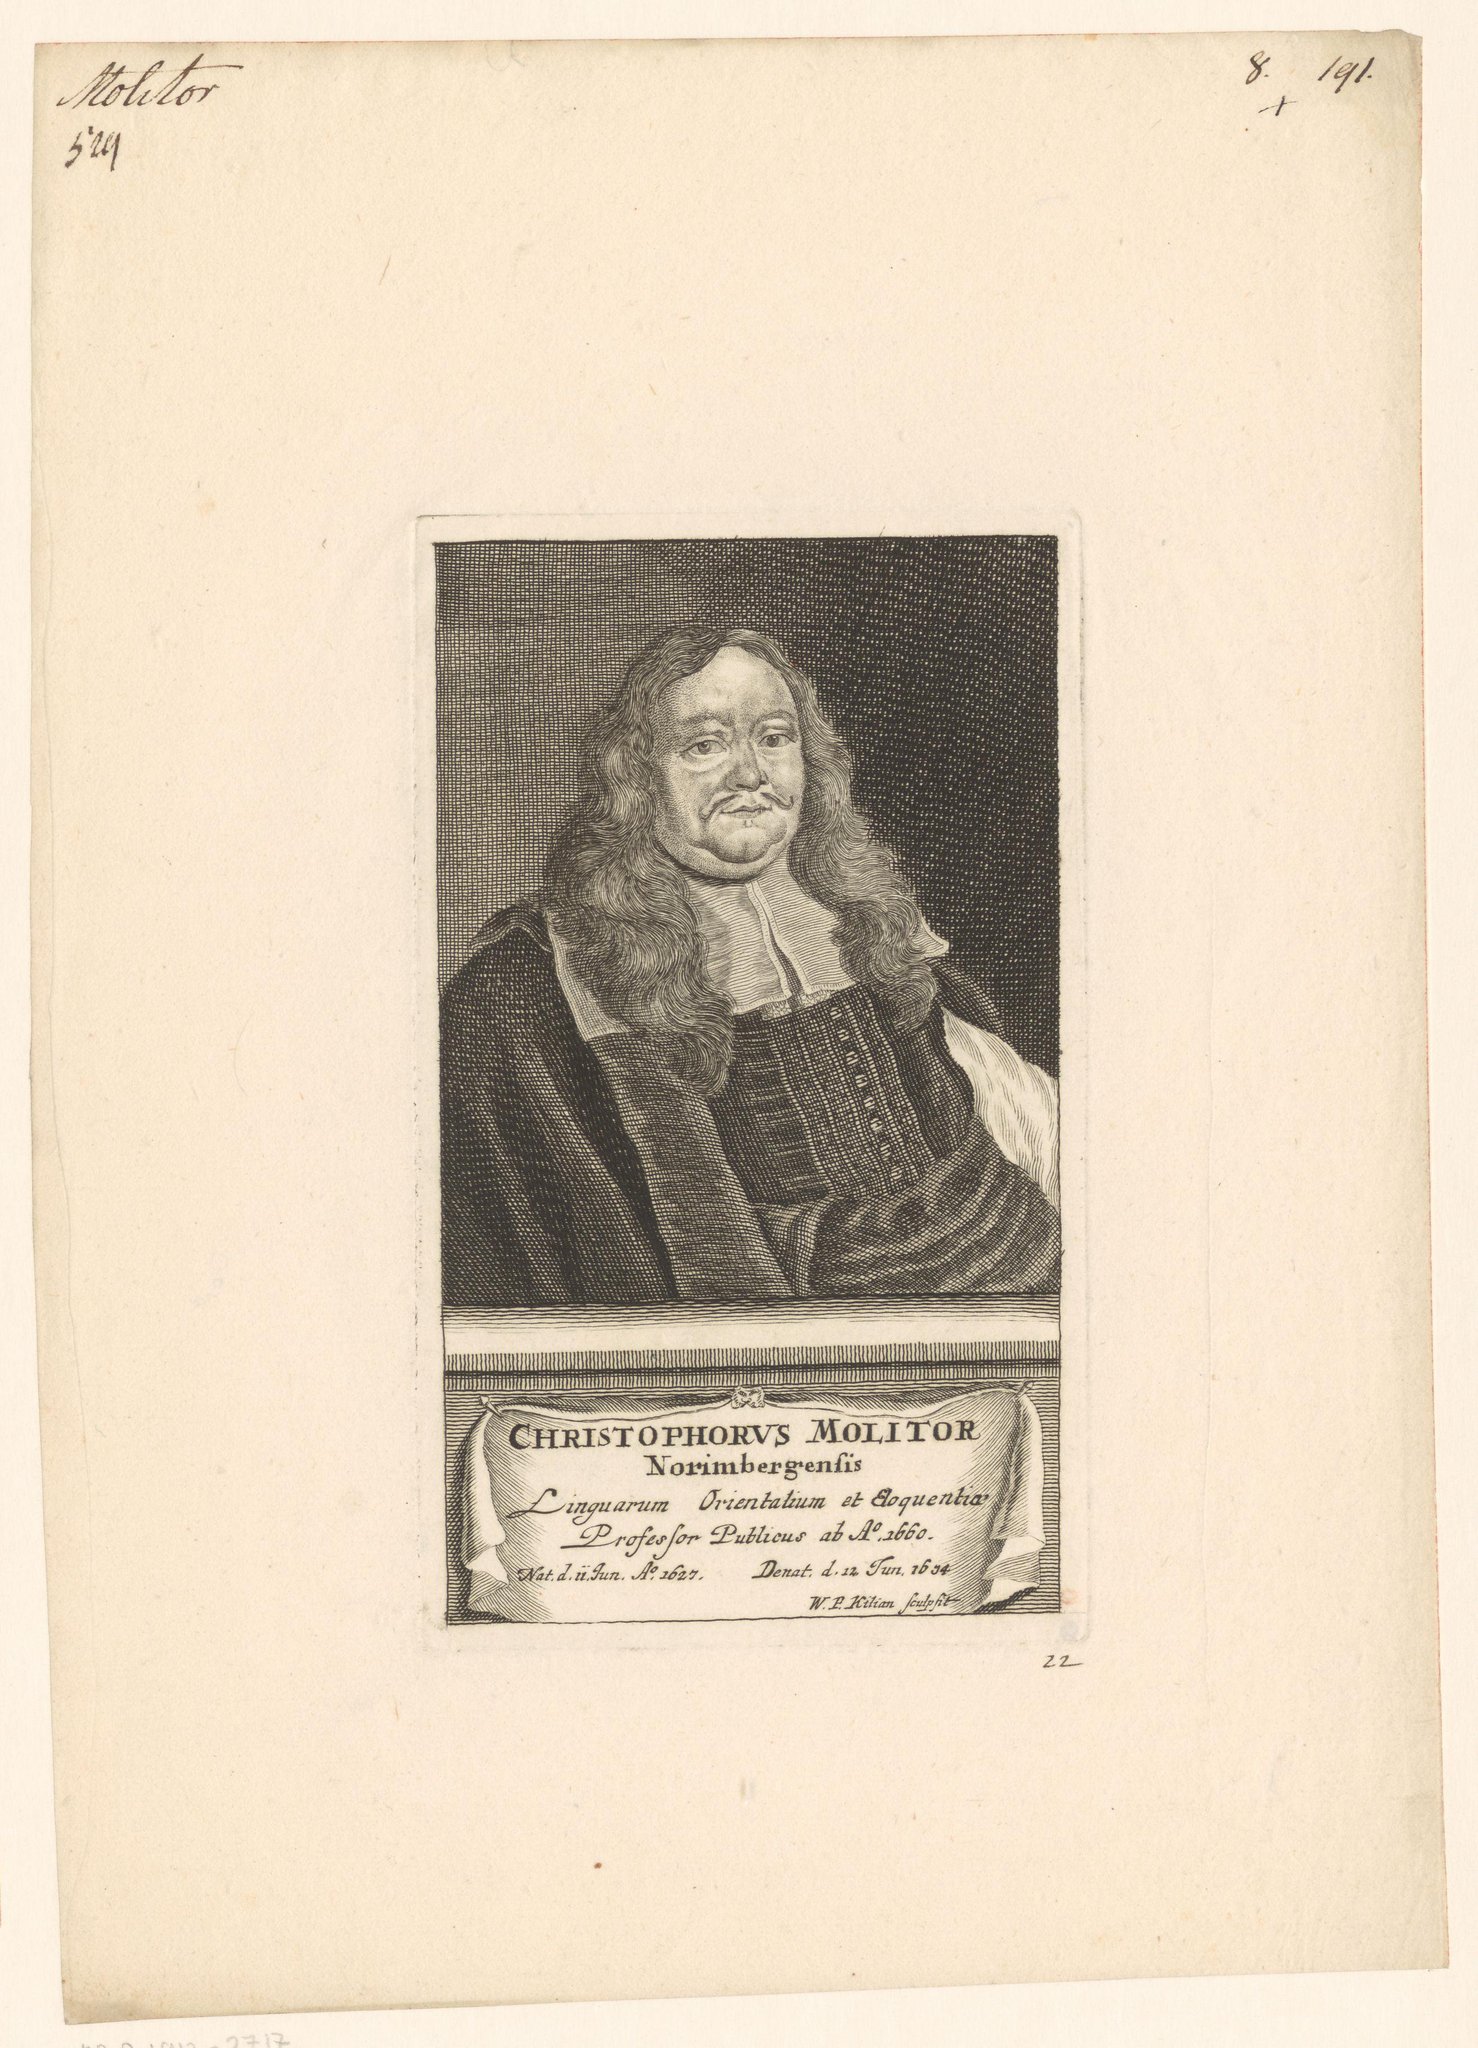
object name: print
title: Portret van Christoph Molitor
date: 1669-1728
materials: paper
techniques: engraving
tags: christoph molitor, historical persons, geography (+ portrait of scholar, scientist)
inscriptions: collector's mark: Lugt 2228, number: ‘22’